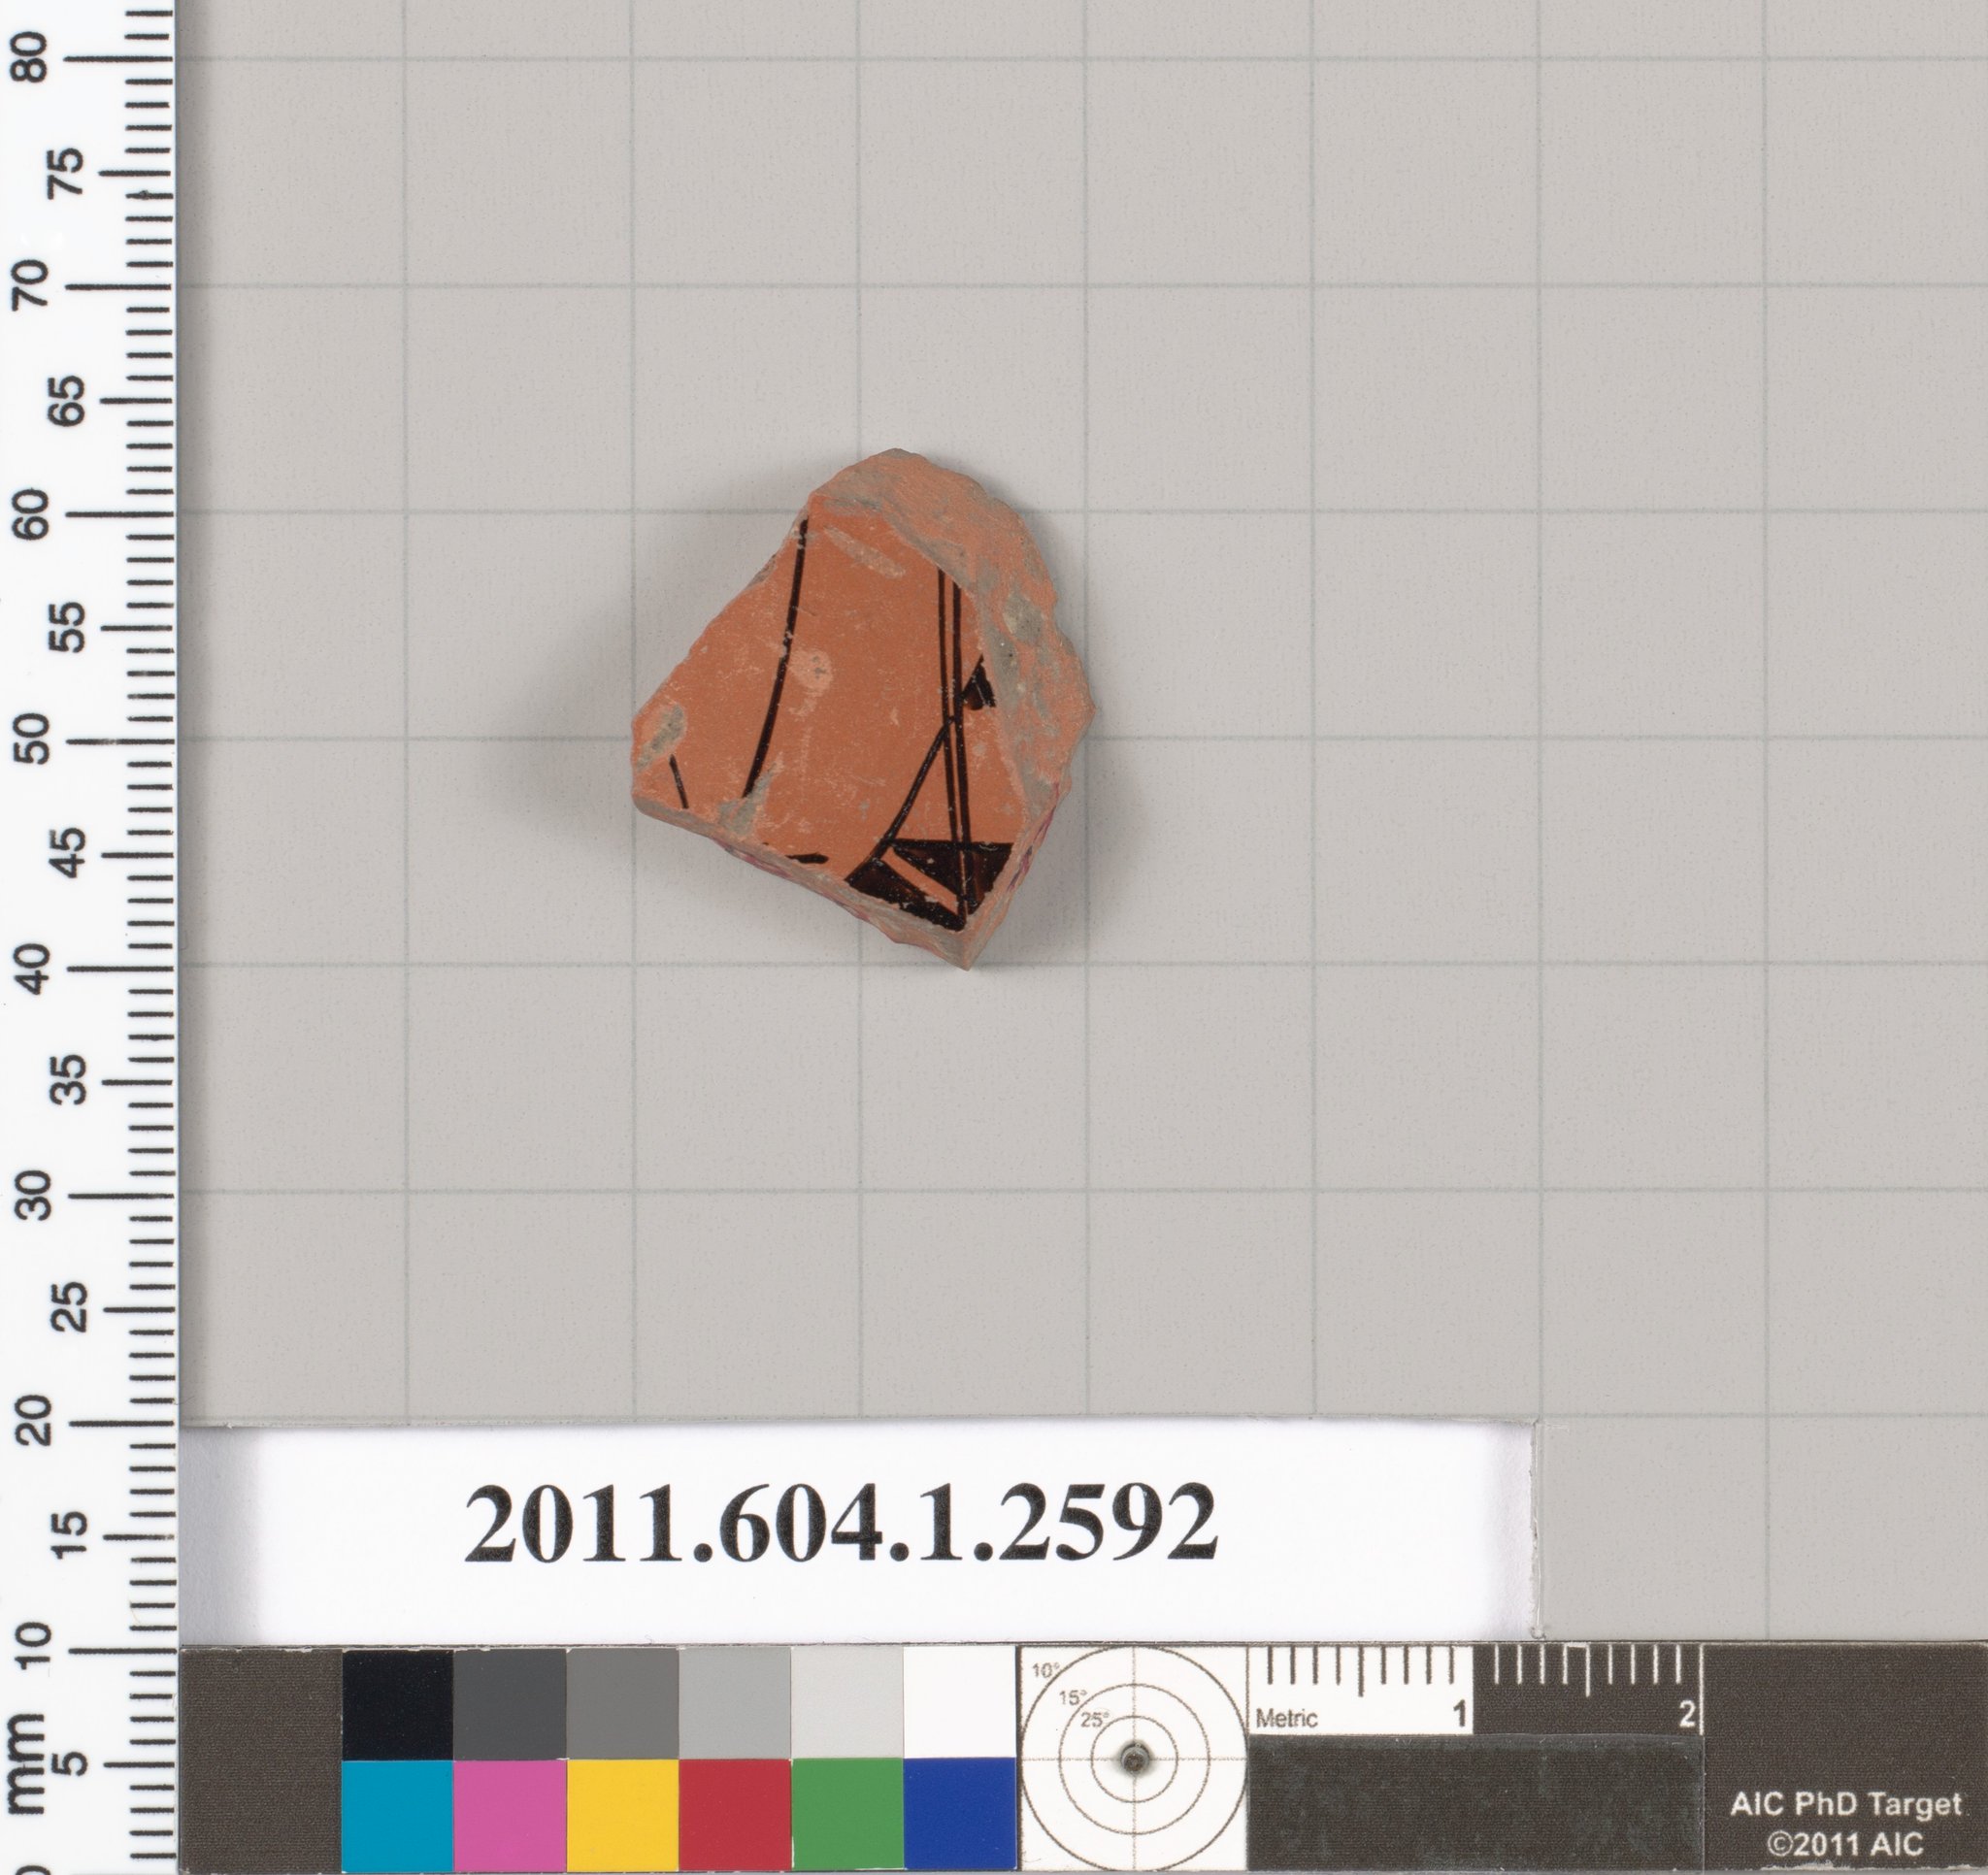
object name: kylix fragment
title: Terracotta fragment of a kylix (drinking cup)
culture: greek, attic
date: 490-480 BCE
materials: terracotta